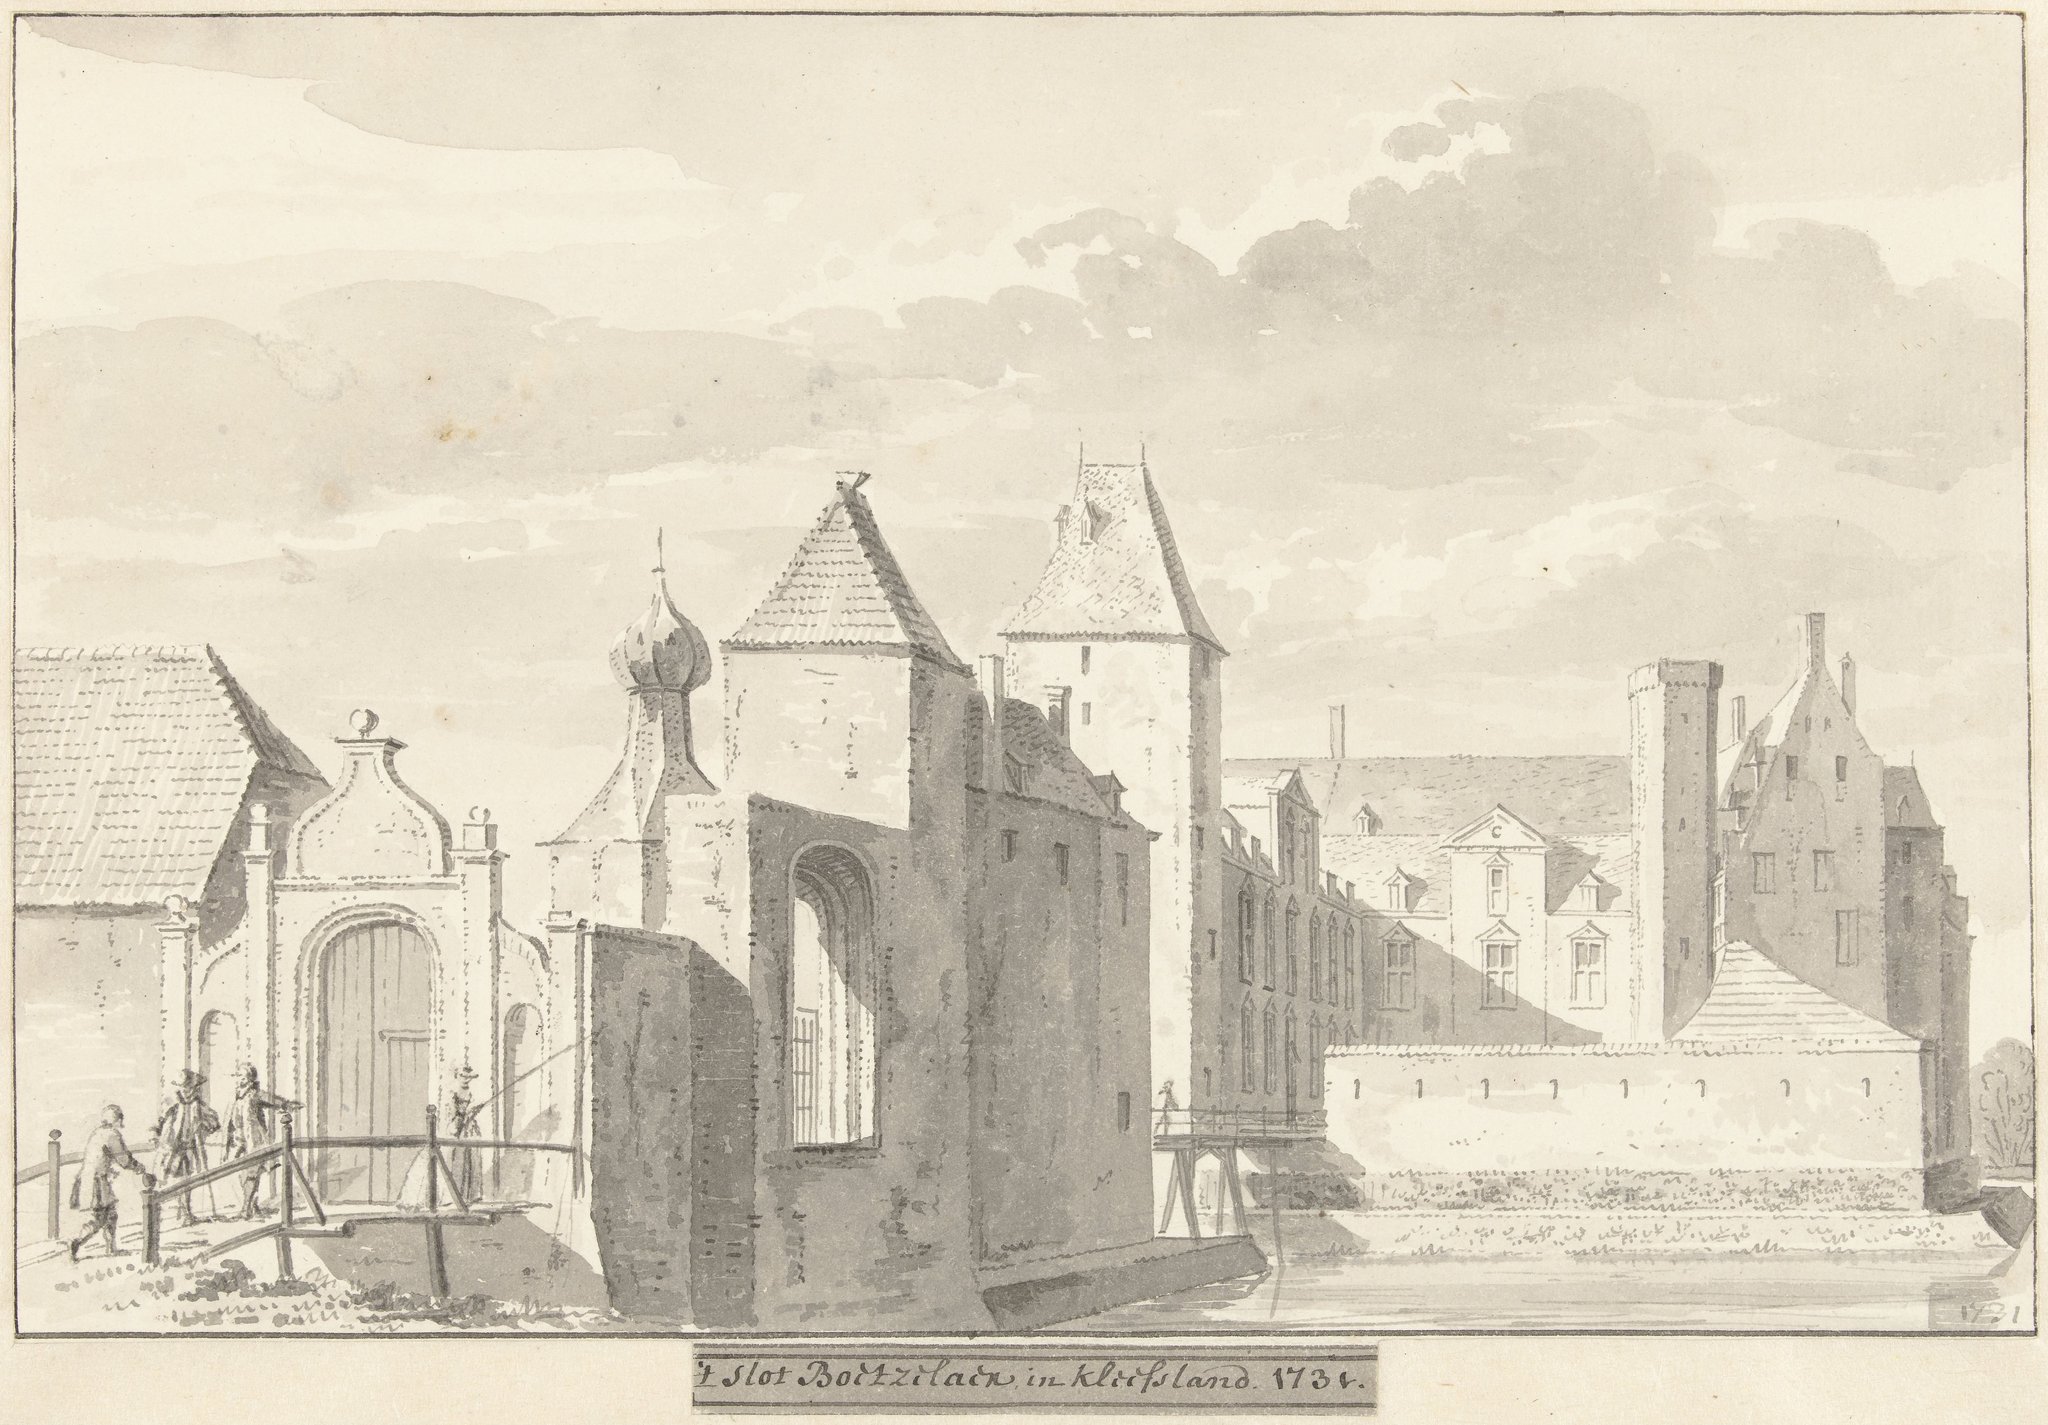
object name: drawing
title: Het slot Boetzelaer in Kleefsland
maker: abraham de haen (ii)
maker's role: draughtsman, print maker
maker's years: 1707-1748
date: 1731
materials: ink, paper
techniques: brush, pen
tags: castle, kalkar